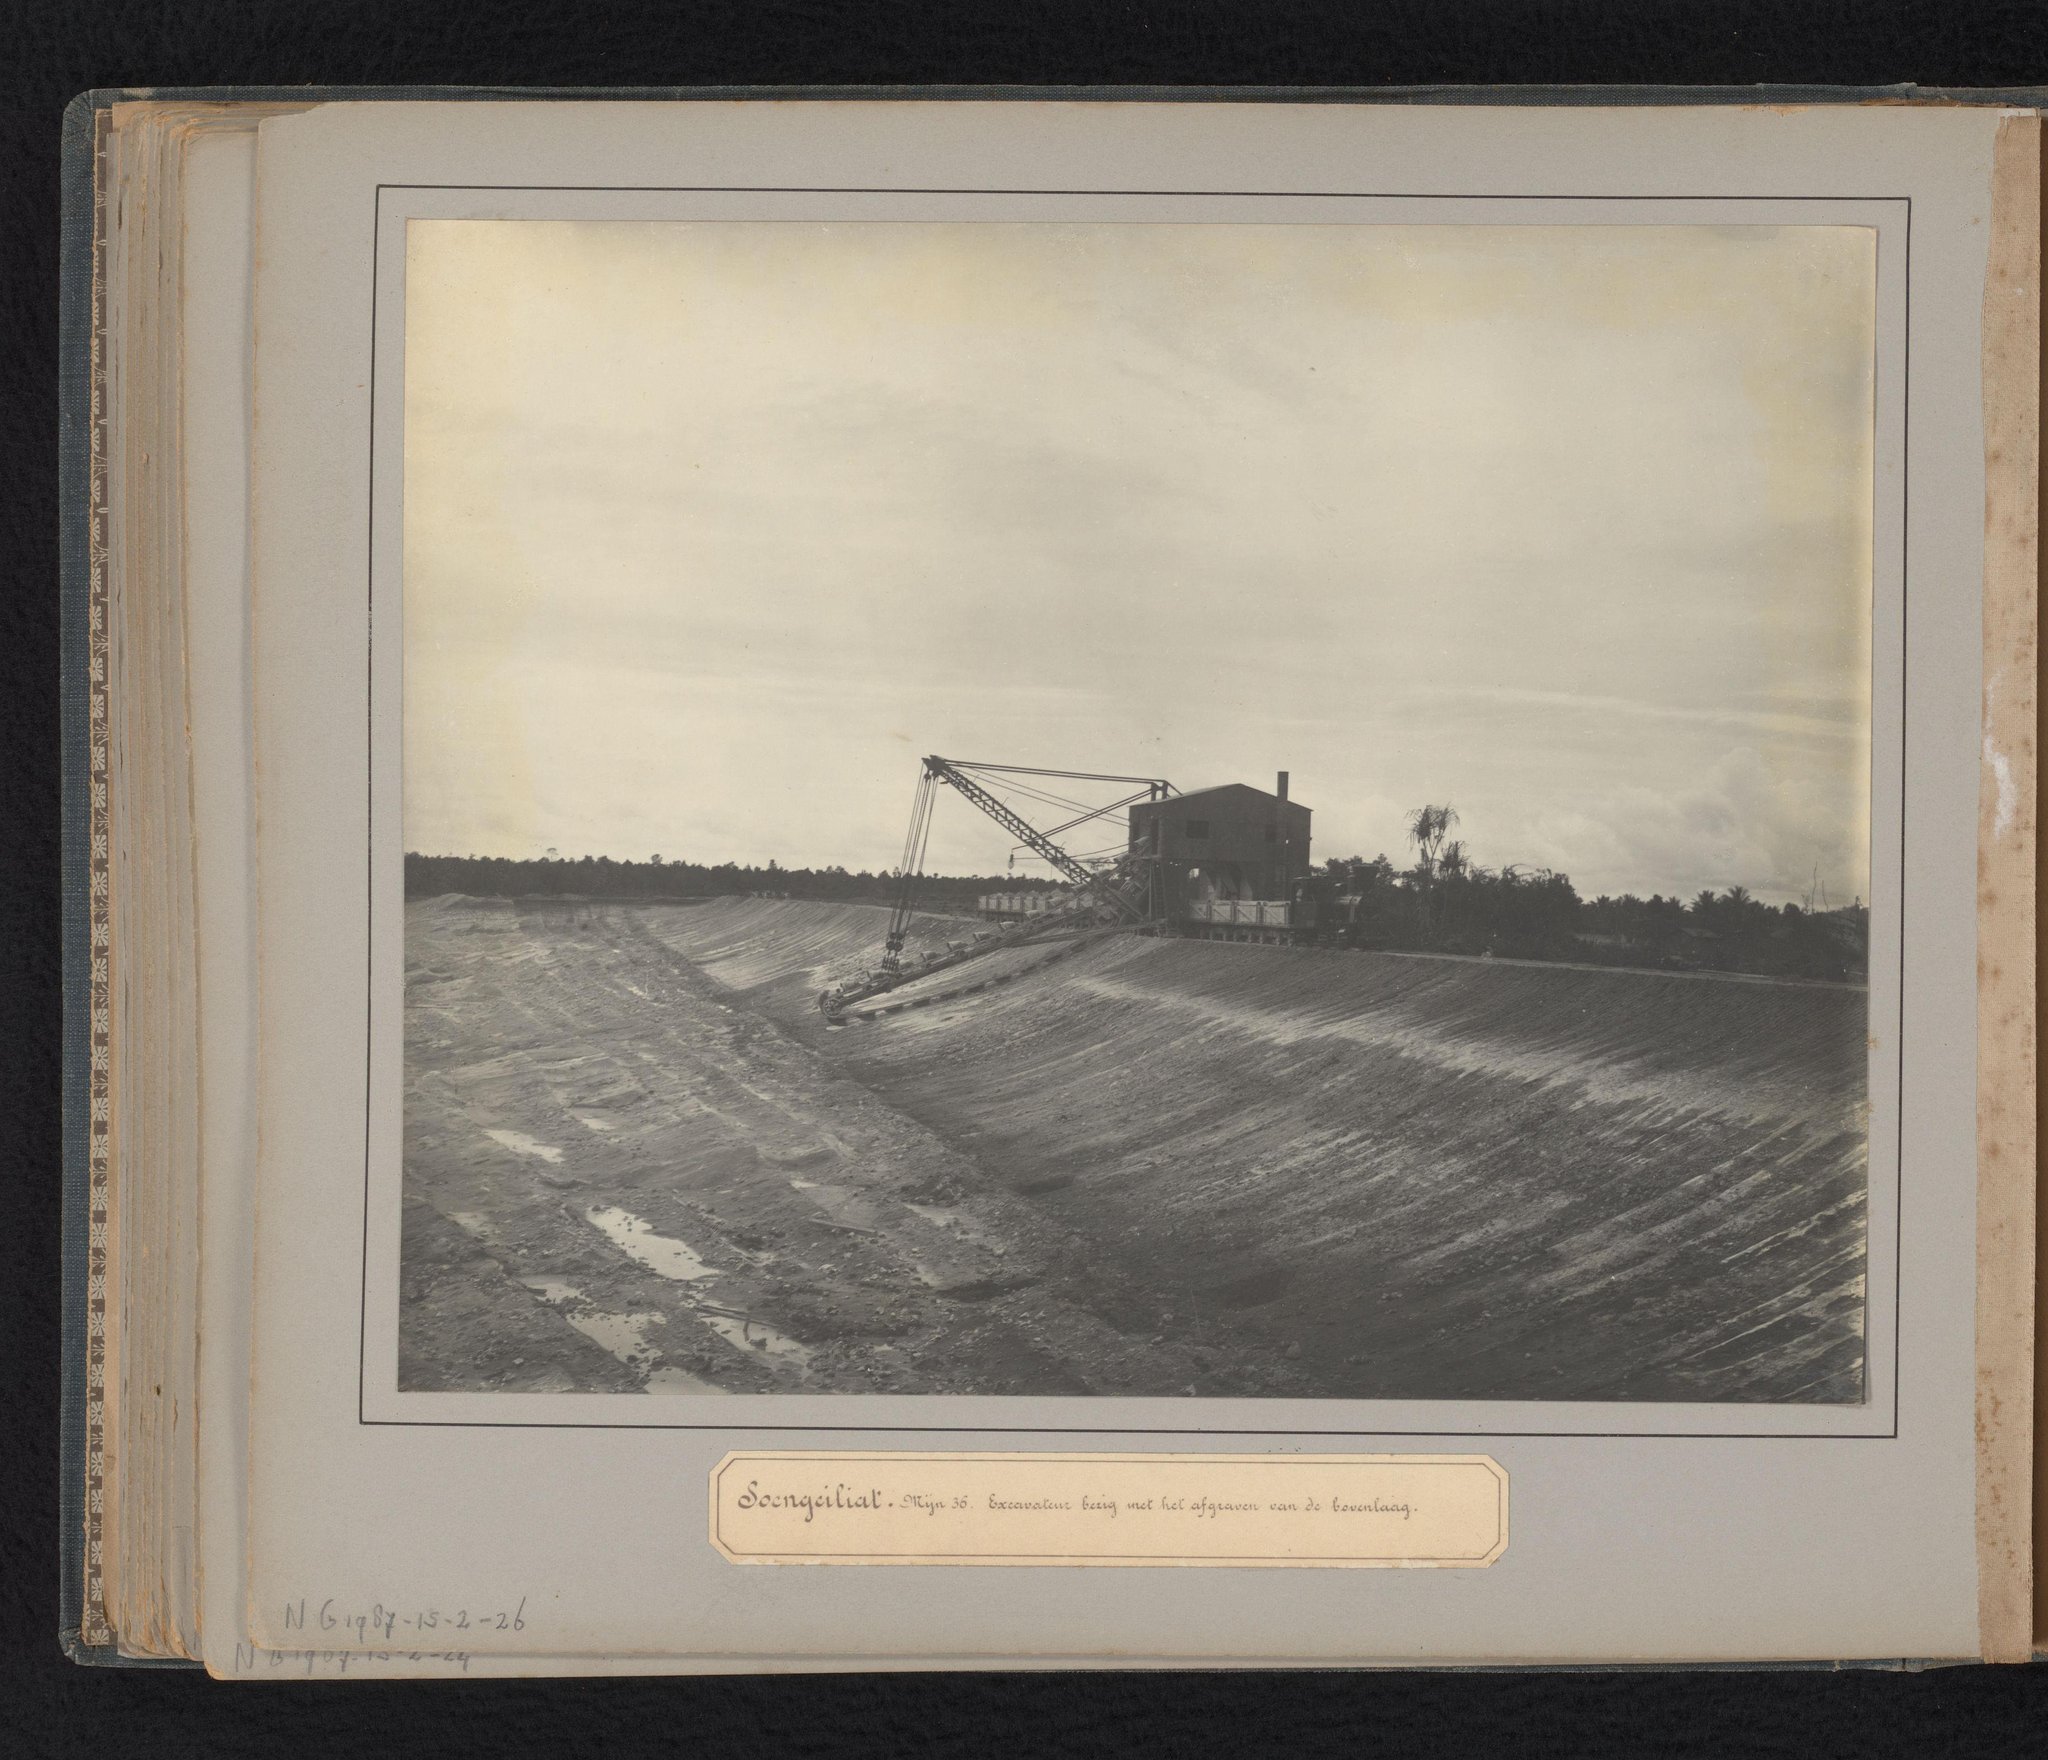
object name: photograph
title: Soengeiliat. Mijn 36. Excavateur bezig met het afgraven van de bovenlaag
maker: Anonymous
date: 1907-1919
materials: cardboard, photographic support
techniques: gelatin silver print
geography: bangka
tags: robert julius boers, colonial system, opencast mine; strip mining, minerals and metals: tin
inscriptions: label: ‘Soengeiliat. Mijn 36. Excavateur bezig met het afgraven van de bovenlaag’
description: Een excavateur verwijdert de bovengrond voor een open tinmijn van de Banka-tinwinning te Soengeiliat. Onderdeel van het fotoalbum over de Banka-tinwinning, ca. 1907-1919.